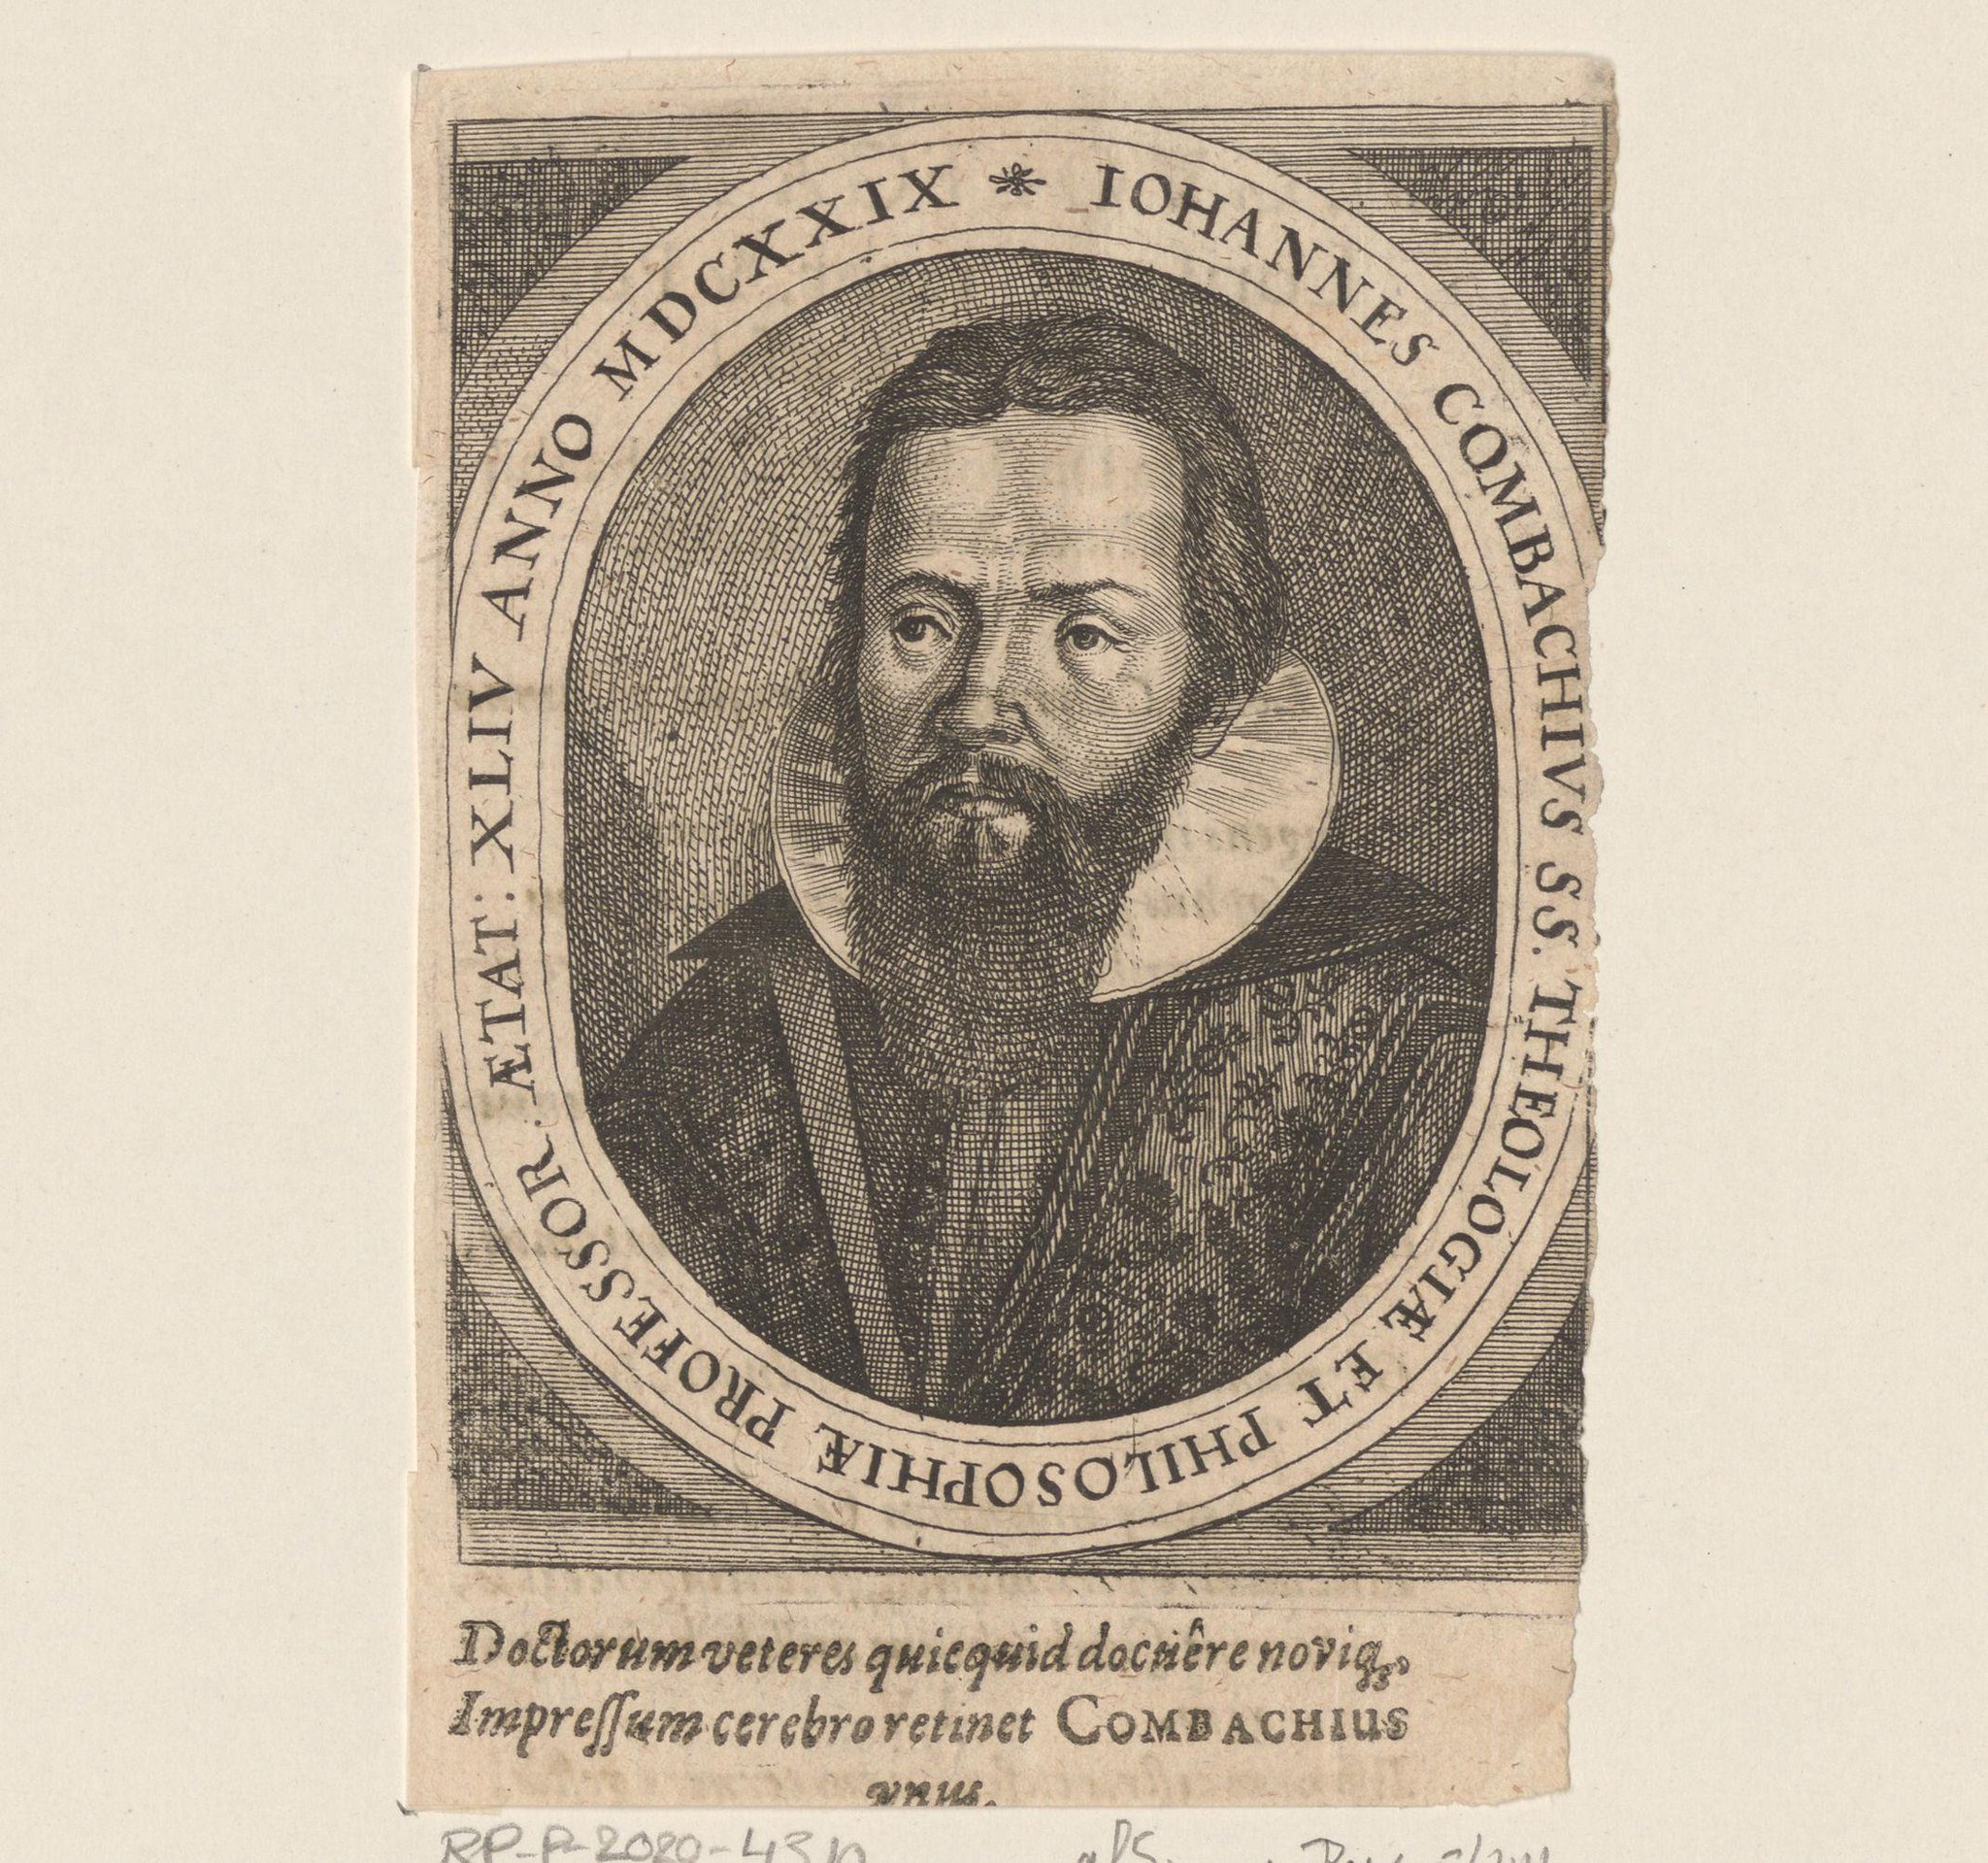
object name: print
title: Portret van Johannes Combach op 44-jarige leeftijd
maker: Anonymous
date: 1629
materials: paper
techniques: engraving, letterpress printing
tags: historical persons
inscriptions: date